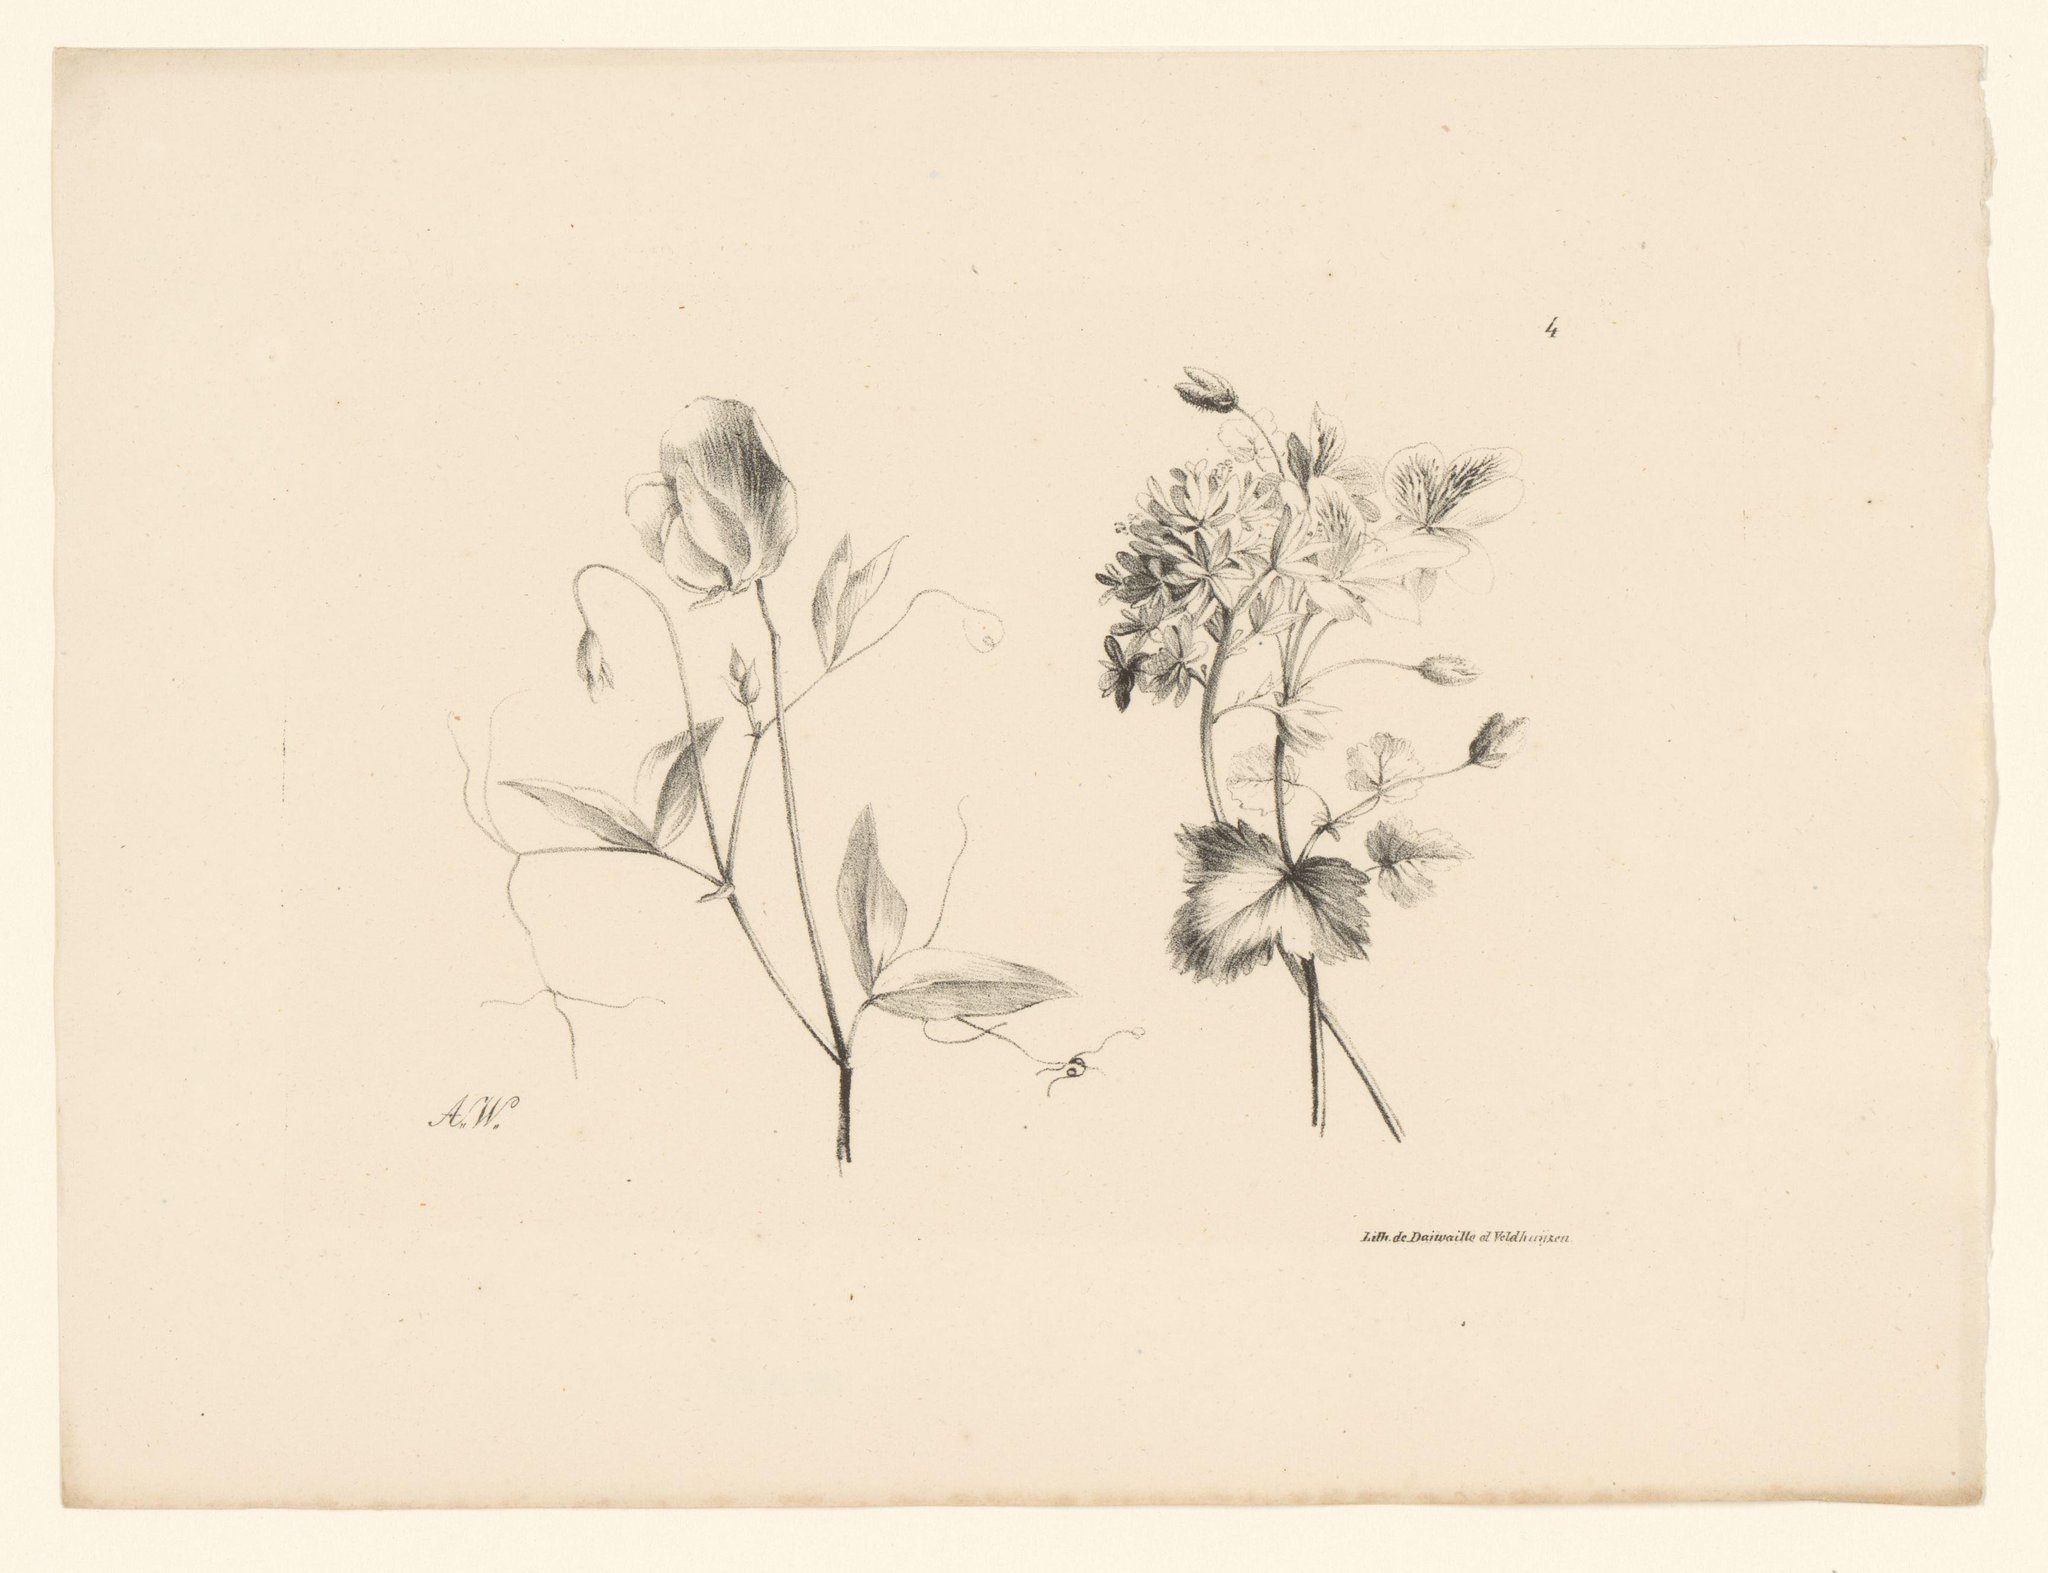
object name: print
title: Twee bloemen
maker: anton weiss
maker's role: draughtsman, print maker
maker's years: 1801-1851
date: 1831-1832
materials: paper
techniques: lithograph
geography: netherlands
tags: flowers